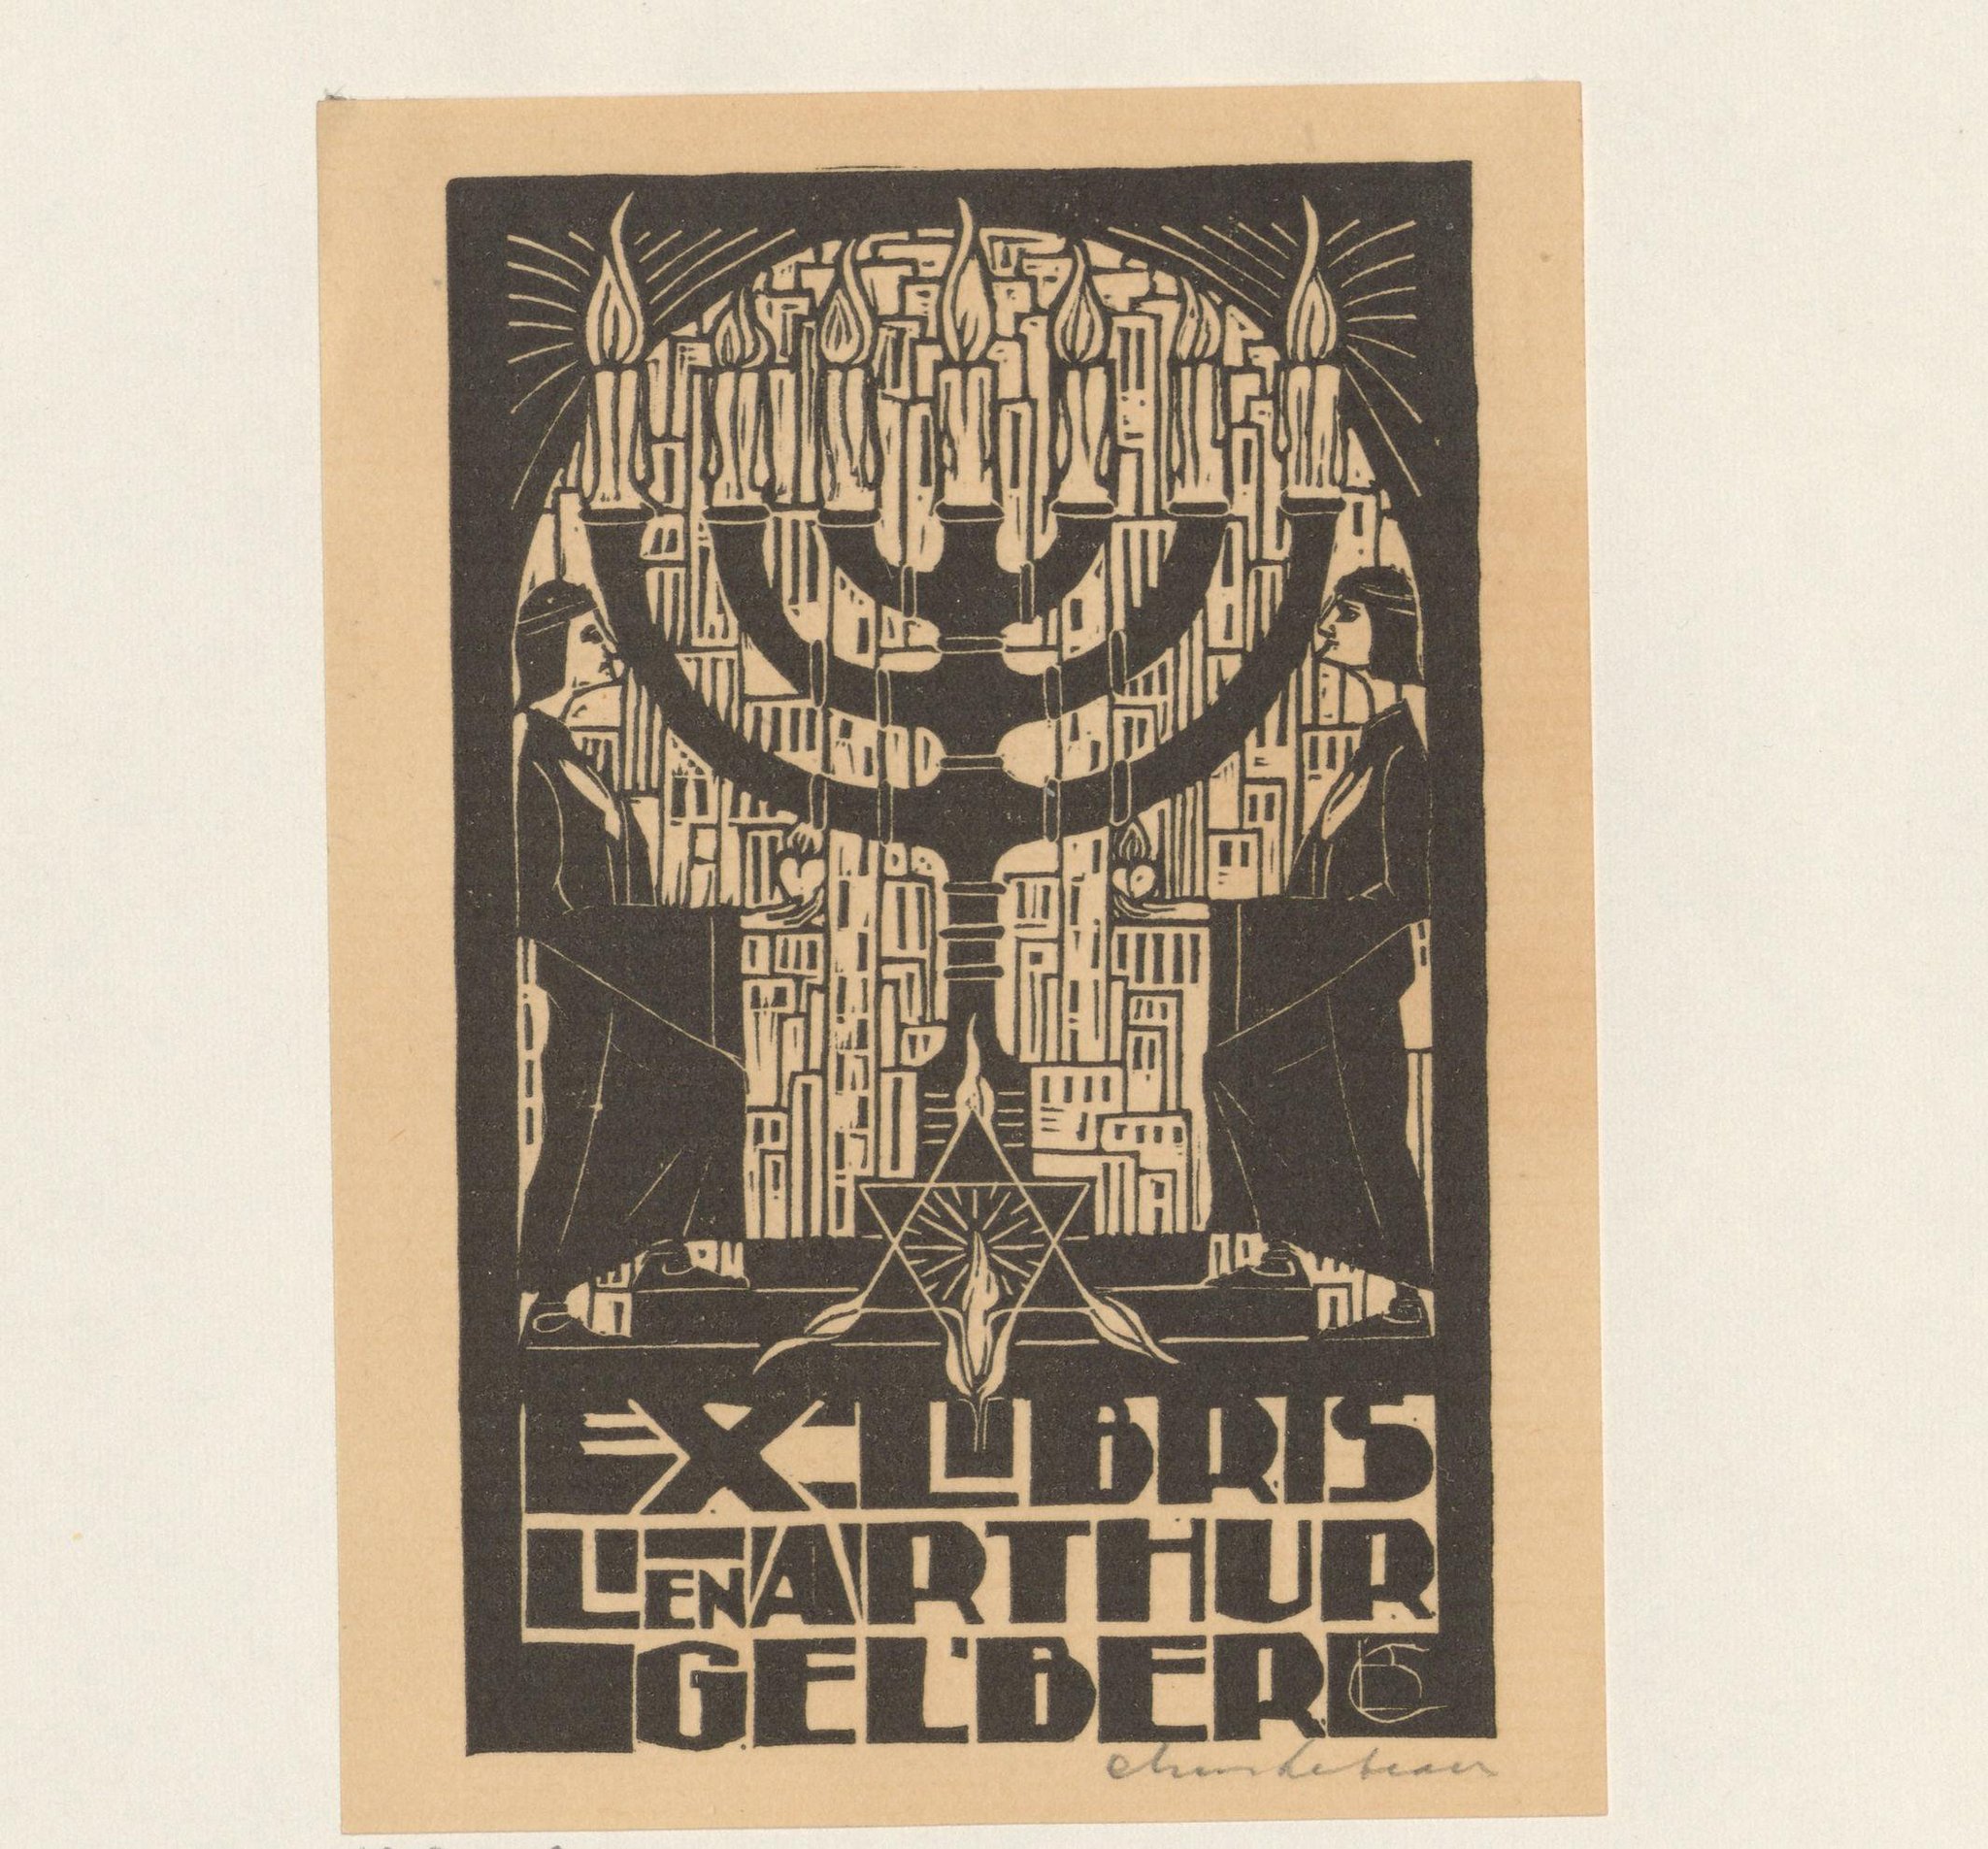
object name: bookplate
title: Ex libris van Li en Arthur Gelber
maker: chris lebeau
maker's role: draughtsman, print maker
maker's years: 1878-1945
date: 1925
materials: paper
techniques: woodcut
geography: netherlands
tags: cologne, symbols, religious and magic concepts, occupations, fashions, realities, general ideas ~ judaism and jewry, seven lamps ~ 'menorah'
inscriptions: signature: ‘Chris Lebeau’